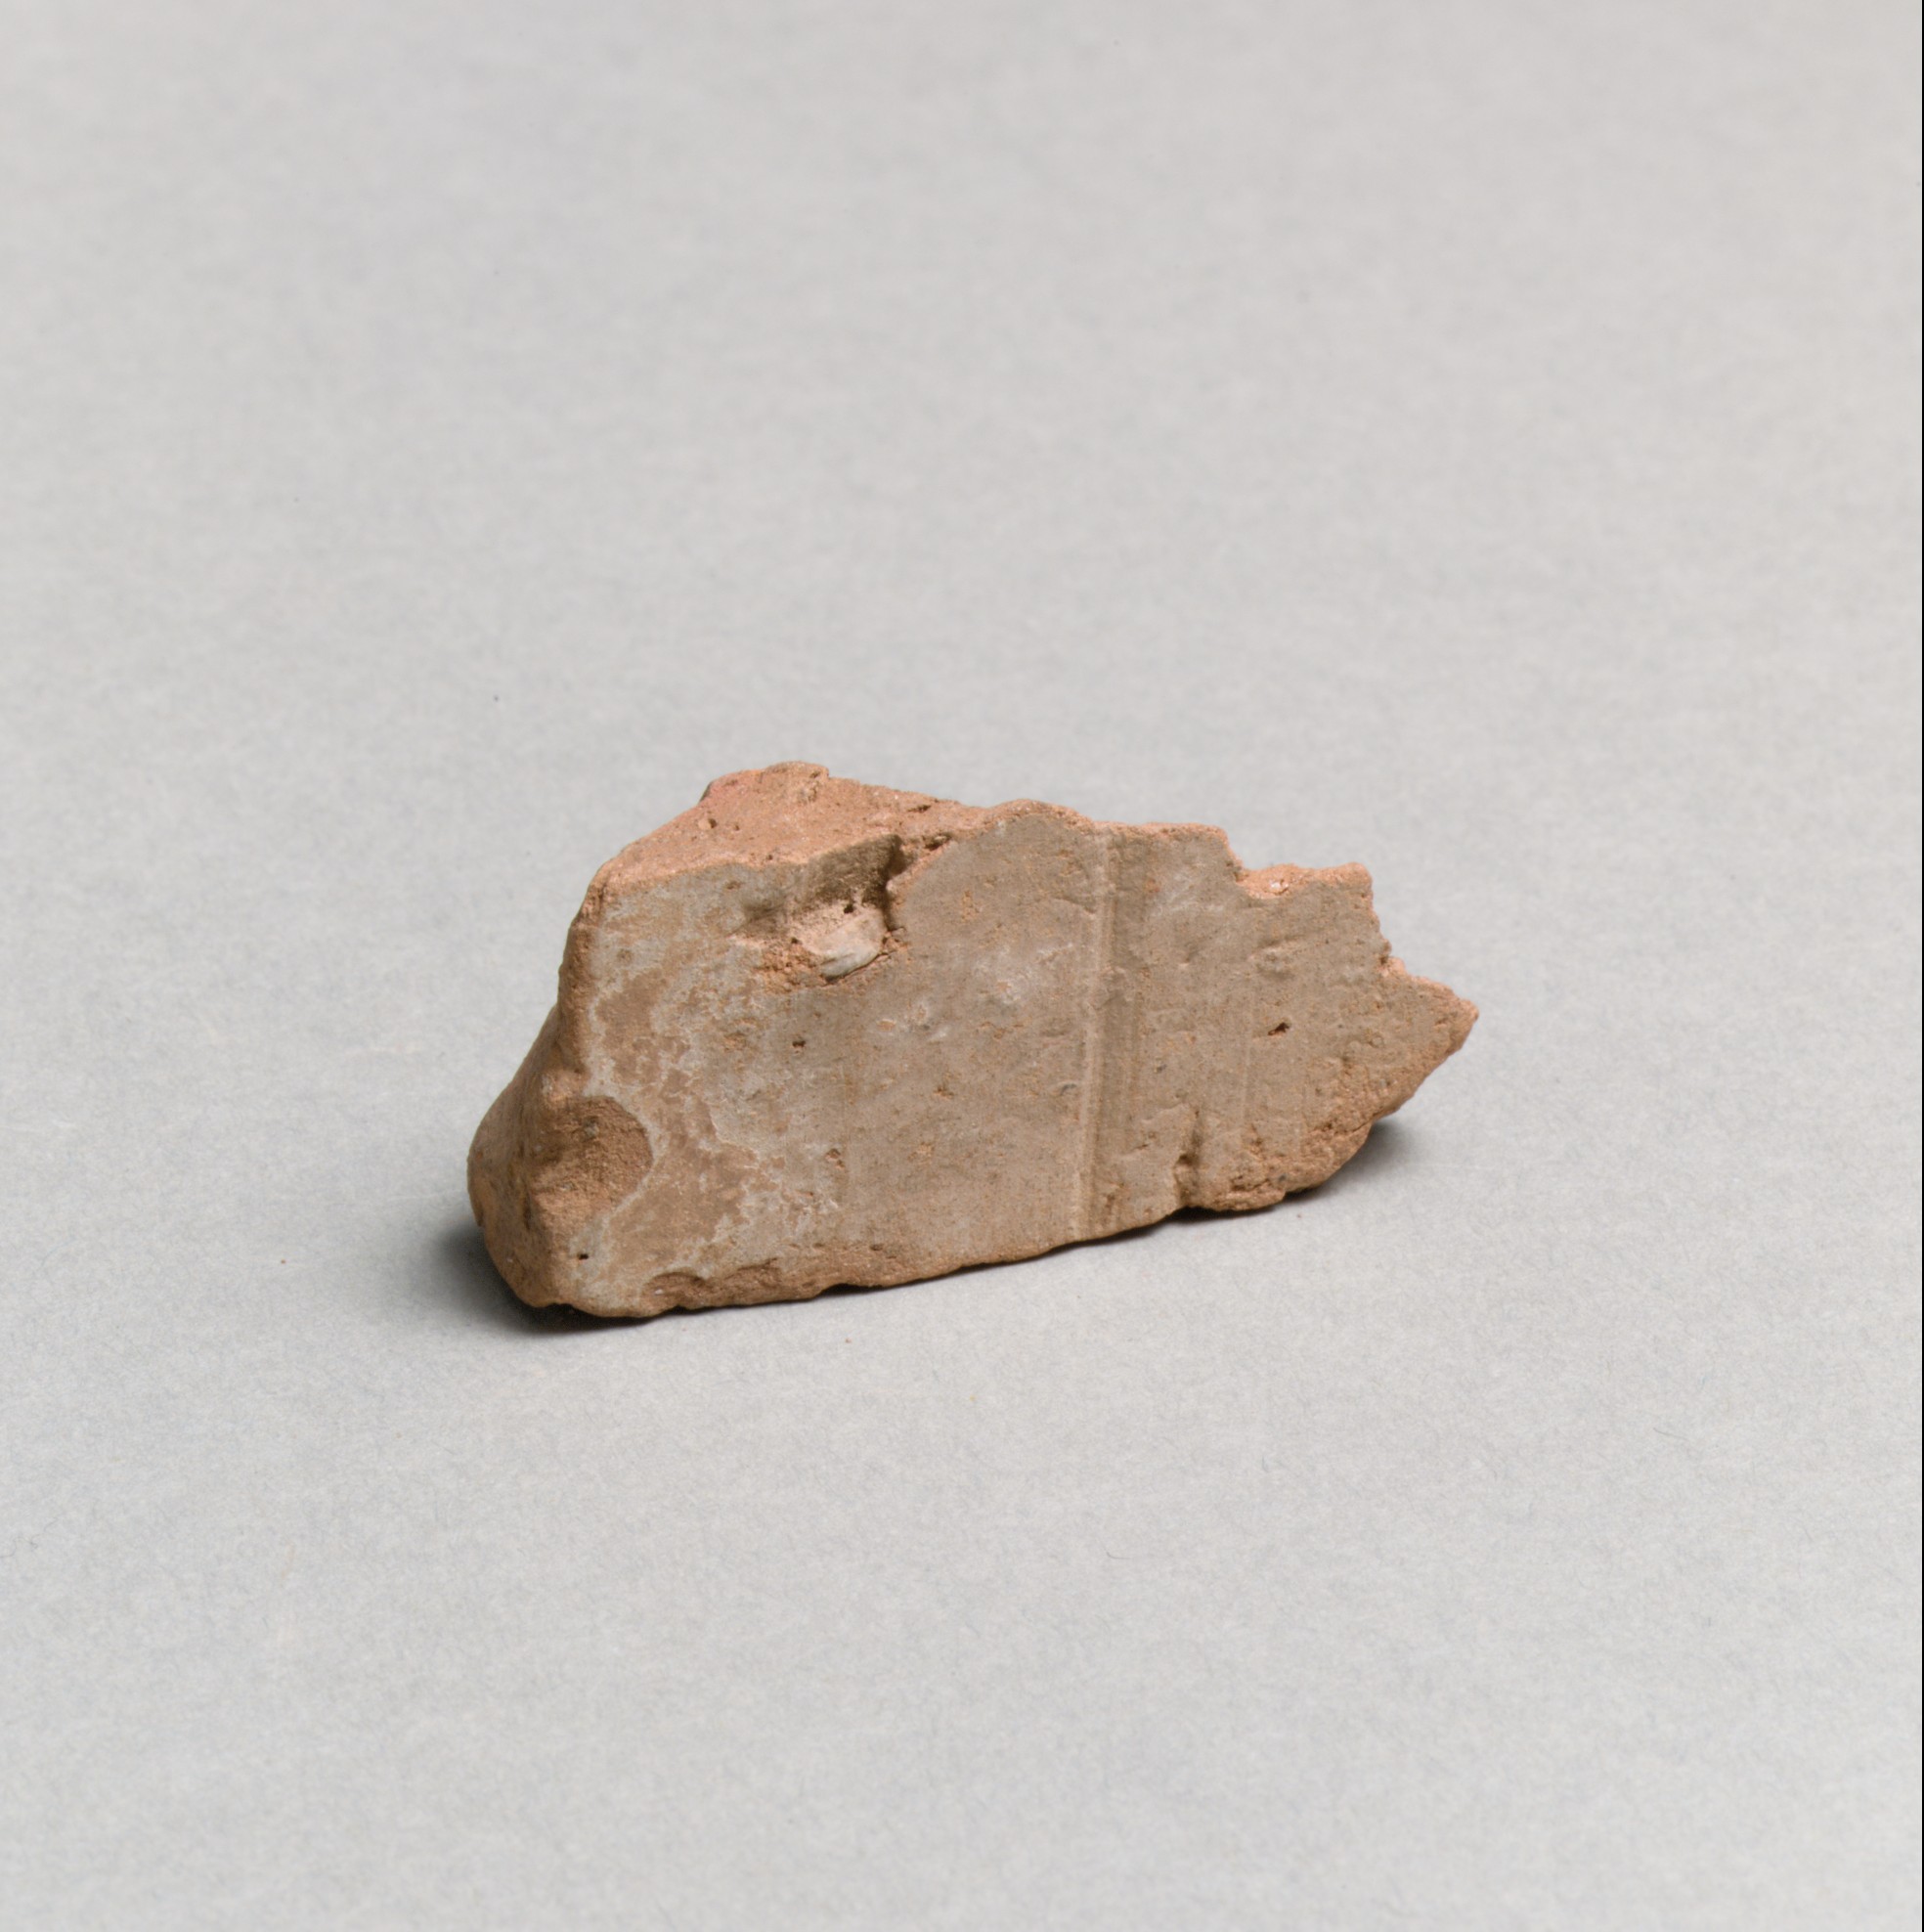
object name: vase fragment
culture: greek, lydian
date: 7000-30 BCE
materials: terracotta